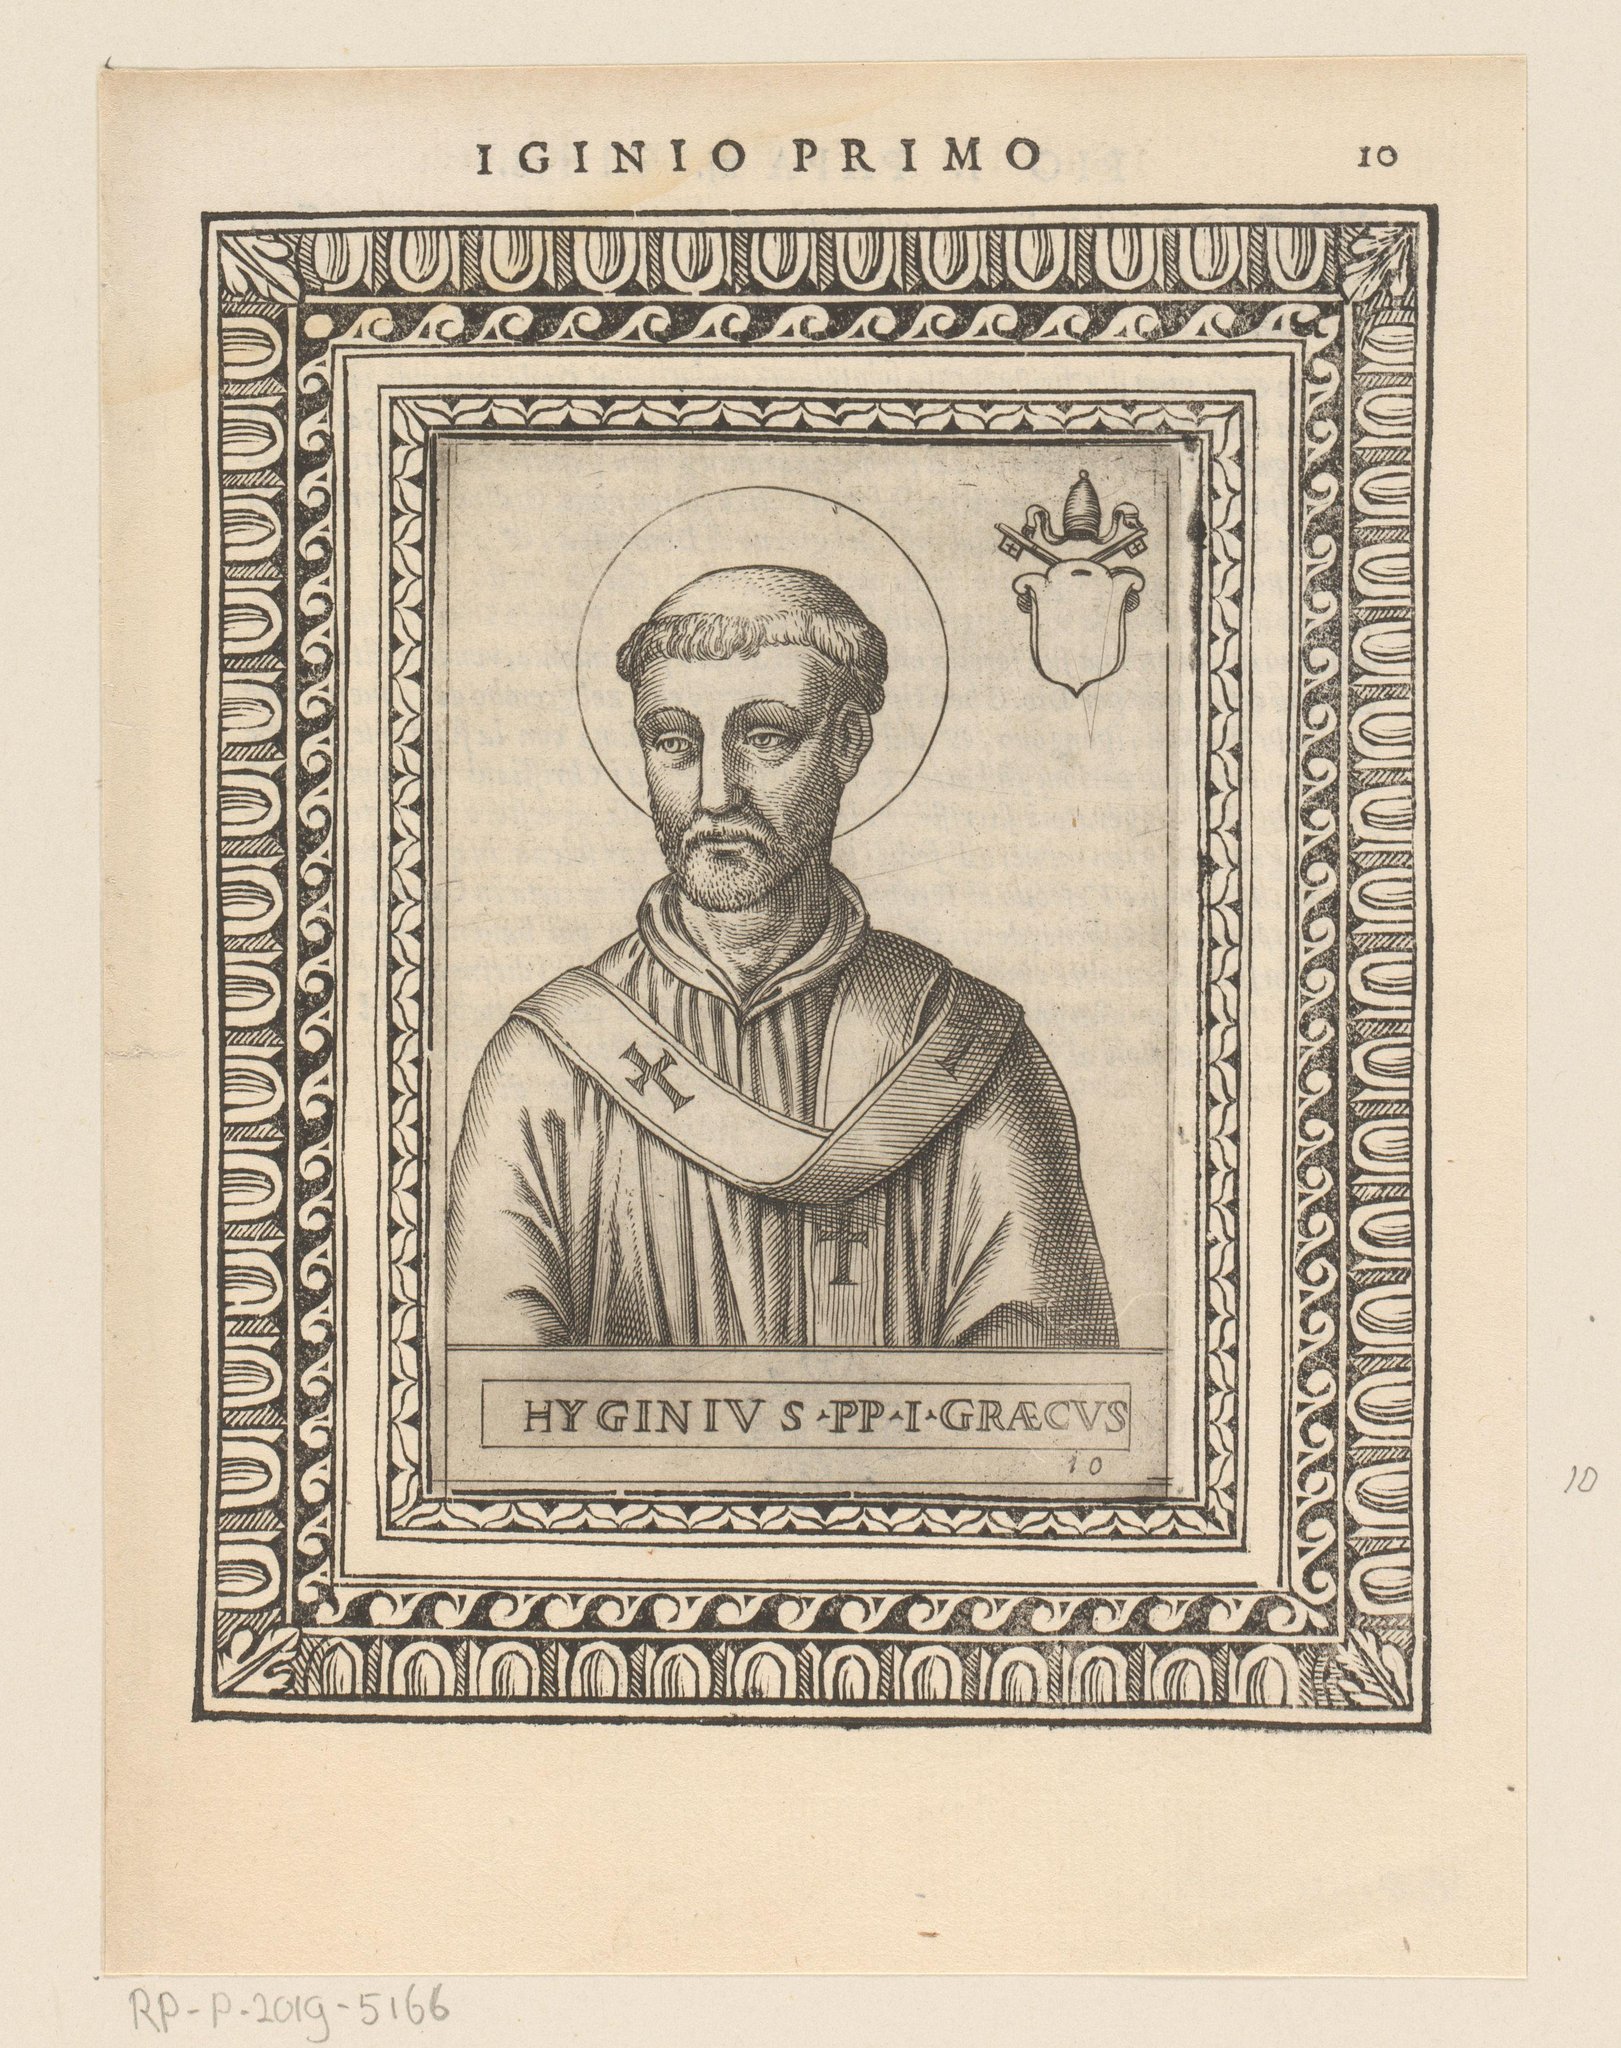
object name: book illustration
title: Portret van paus Hyginus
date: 1587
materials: paper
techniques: engraving, letterpress printing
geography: rome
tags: historical persons, pope, armorial bearing, heraldry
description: Prent uit: Ciccarelli, Antonio. Le vite de Pontefici di Antonio Ciccarelli (...). Rome: Domenico Basa, 1587. Prent voor het eerst verschenen in: Cavalieri, Giovanni Battista de'. Pontificum romanorum effigies (...). Rome: Domenico Basa en Francesco Zanetti, 1580. Prent ook gebruikt in latere publicaties.